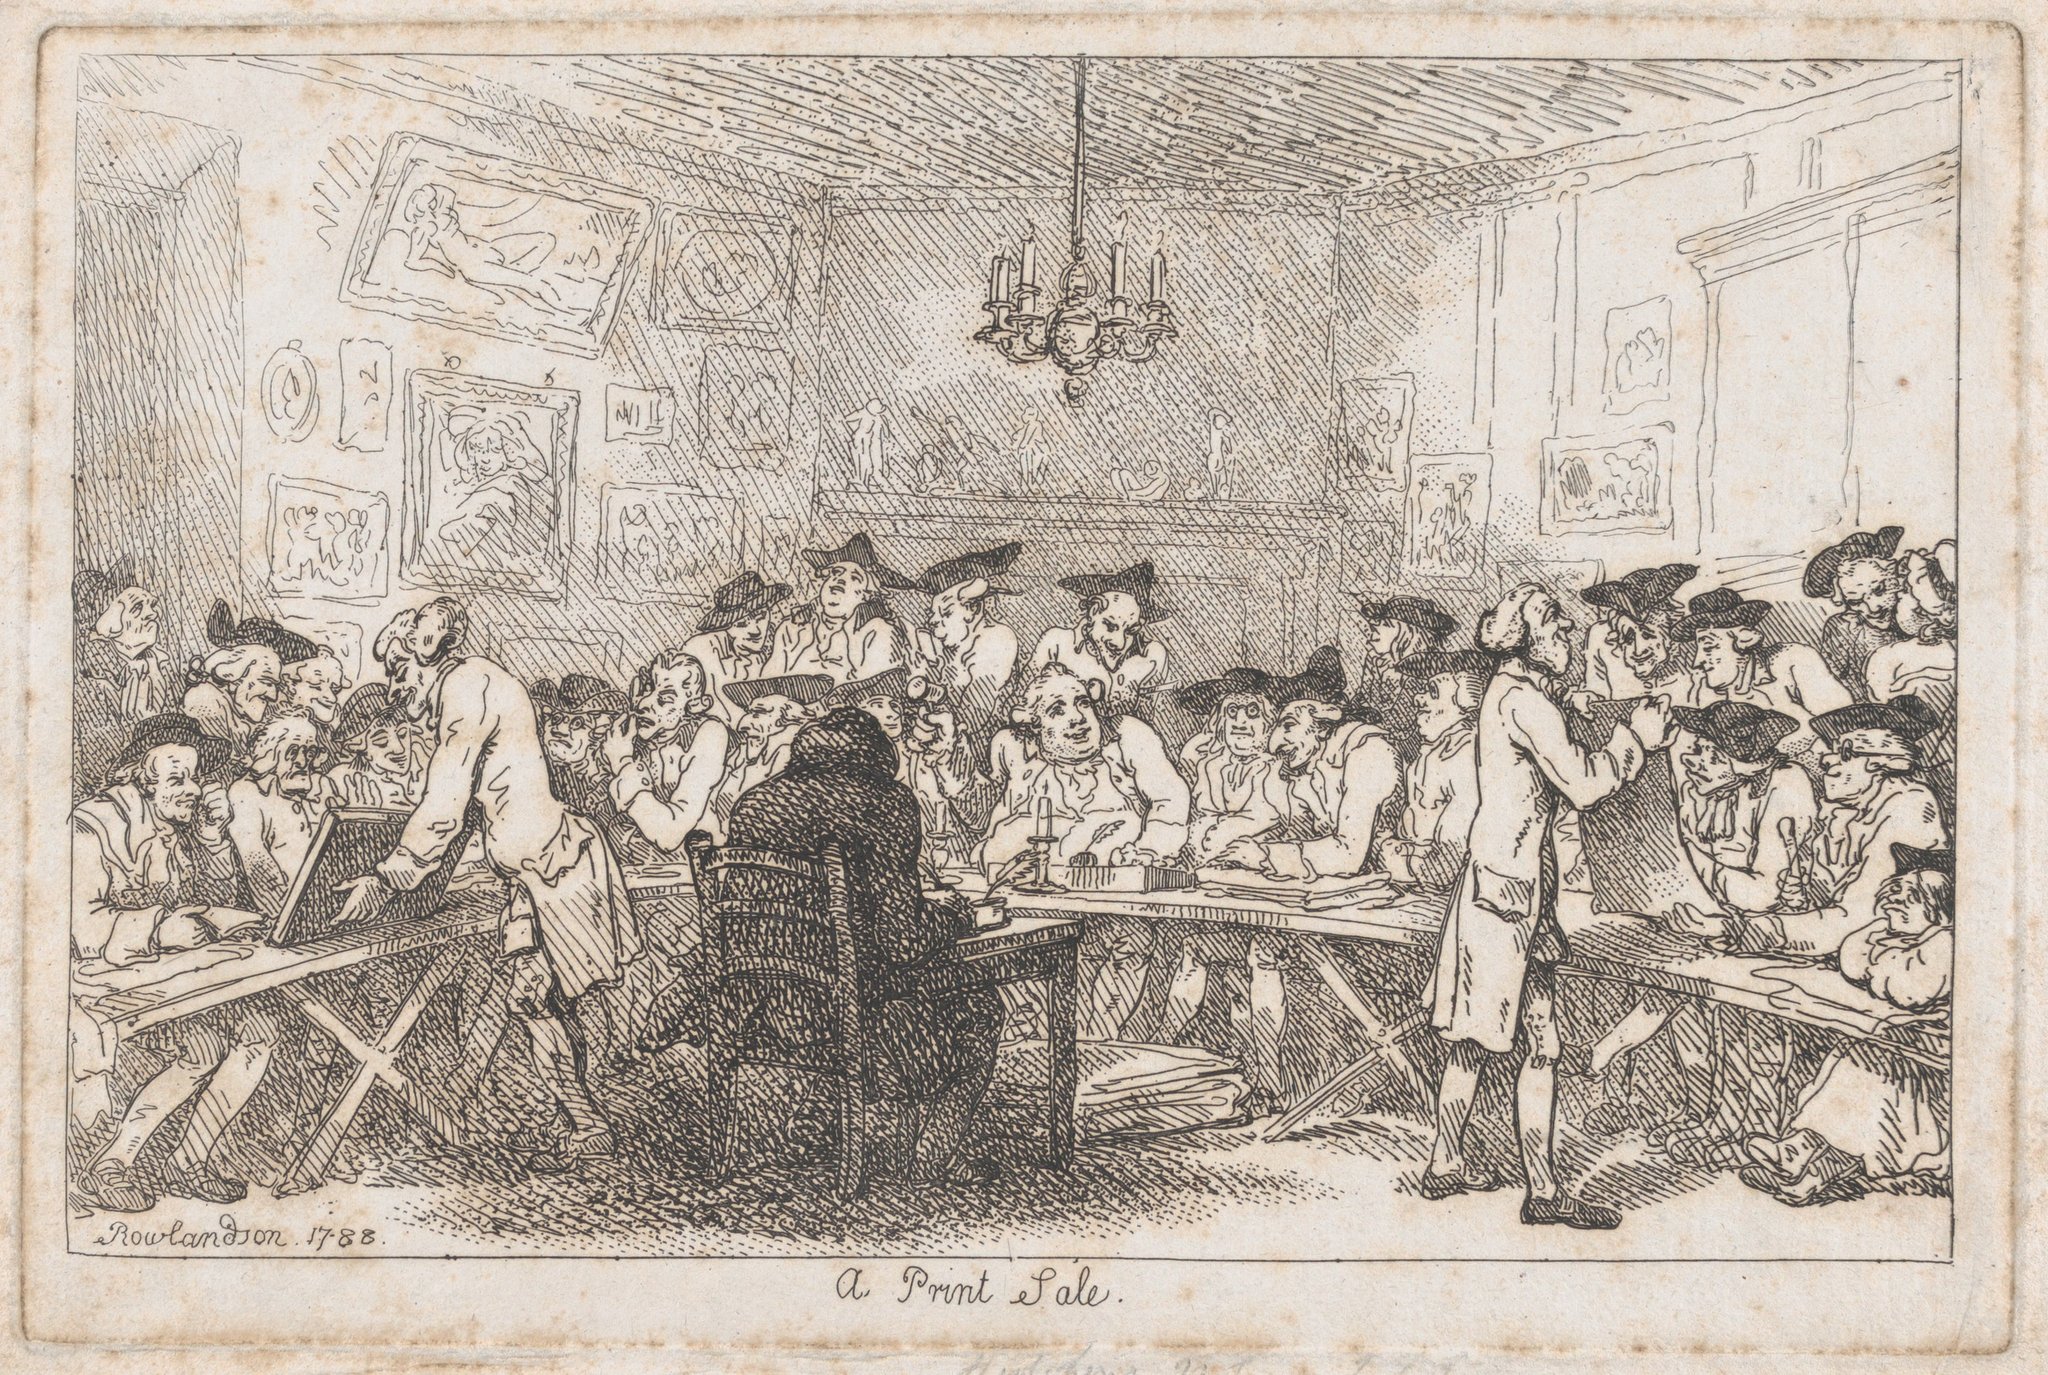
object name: print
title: A Print Sale – A Night Auction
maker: thomas rowlandson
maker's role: artist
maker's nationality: british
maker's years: 1757-1827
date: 1788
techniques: etching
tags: men